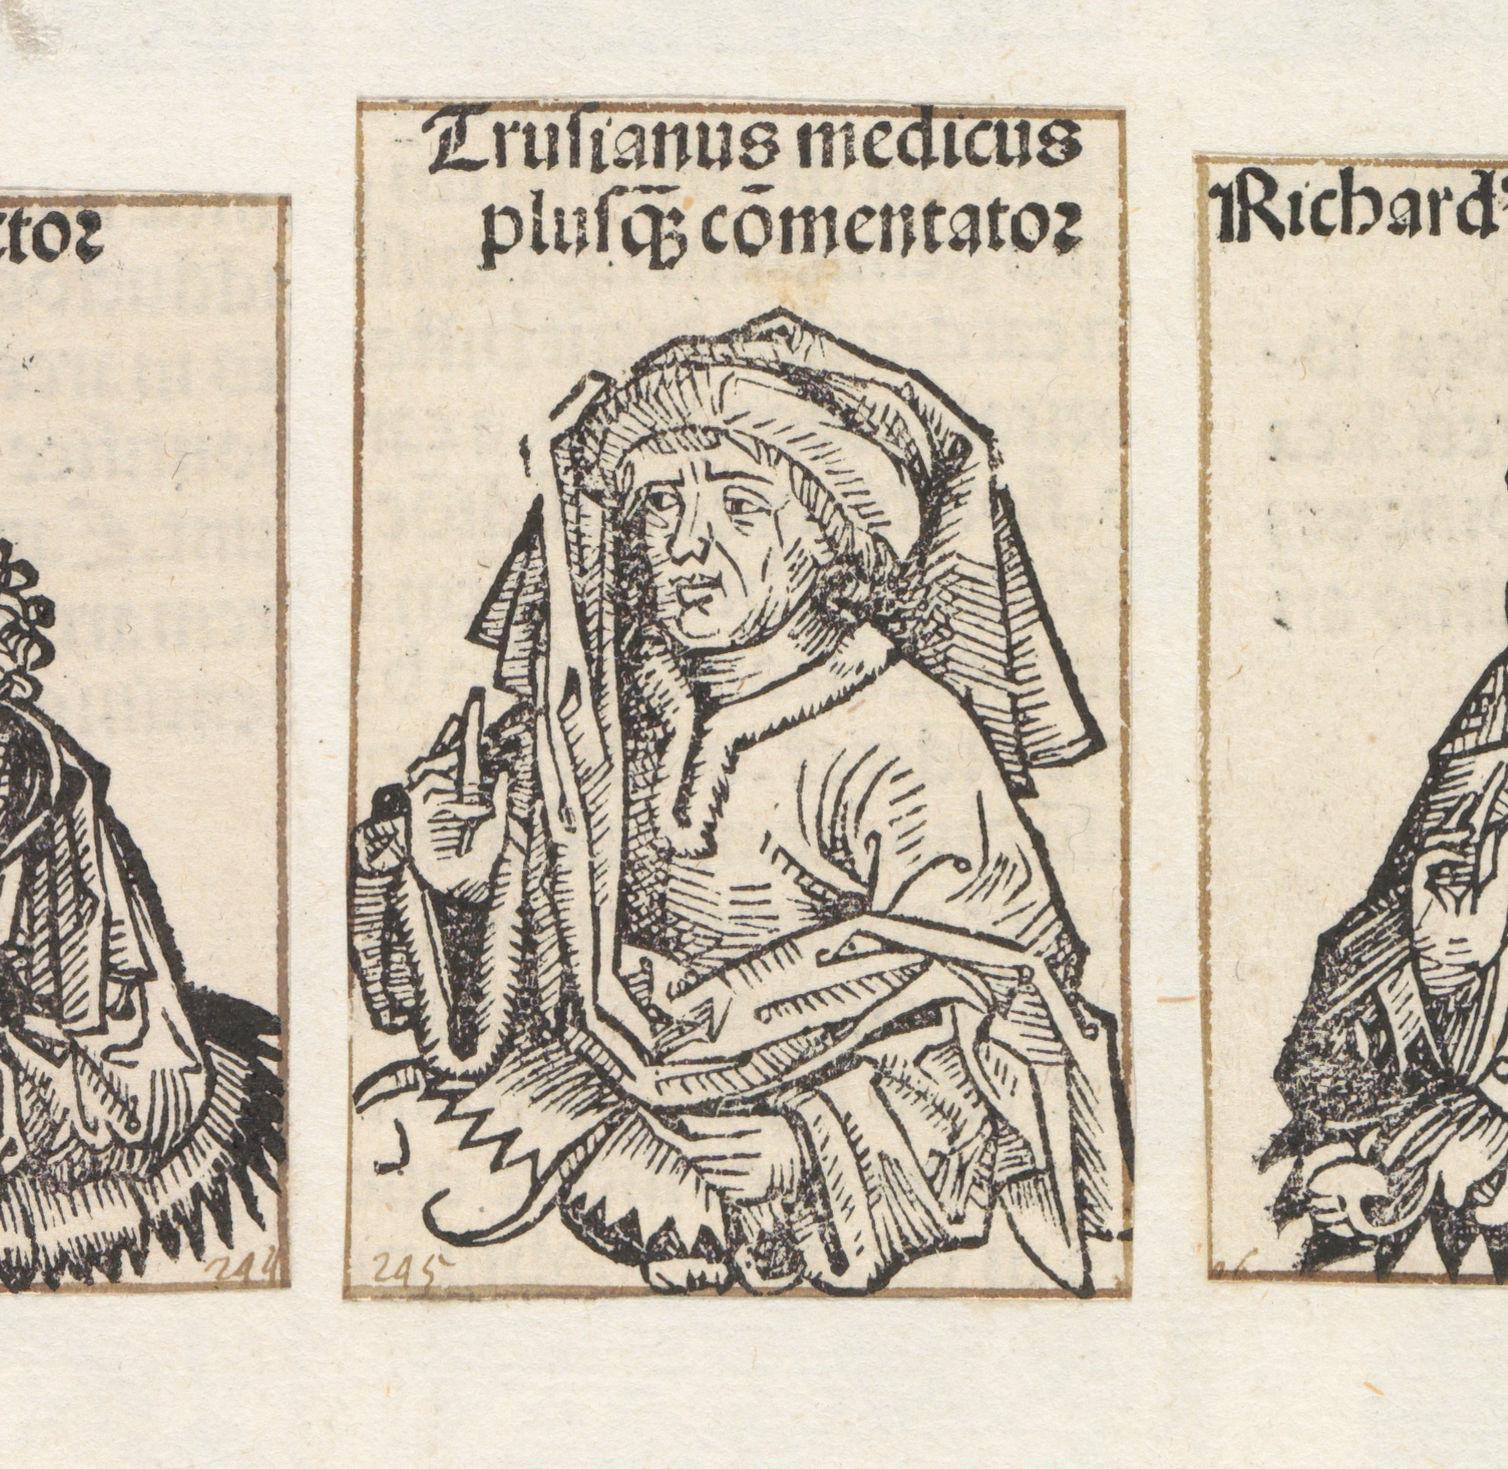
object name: album leaf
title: Trusianus medicus plusque co[m]mentator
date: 1493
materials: paper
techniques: letterpress printing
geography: nuremberg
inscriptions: inscription: ‘245’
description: De houtsnede wordt herhaaldelijk gebruikt als boekillustratie in de Liber Chronicarum (of Neurenbergkroniek) van Hartmann Schedel, verschenen in het Latijn en Duits in 1493. Zie de Latijnse uitgave, folio 222v.